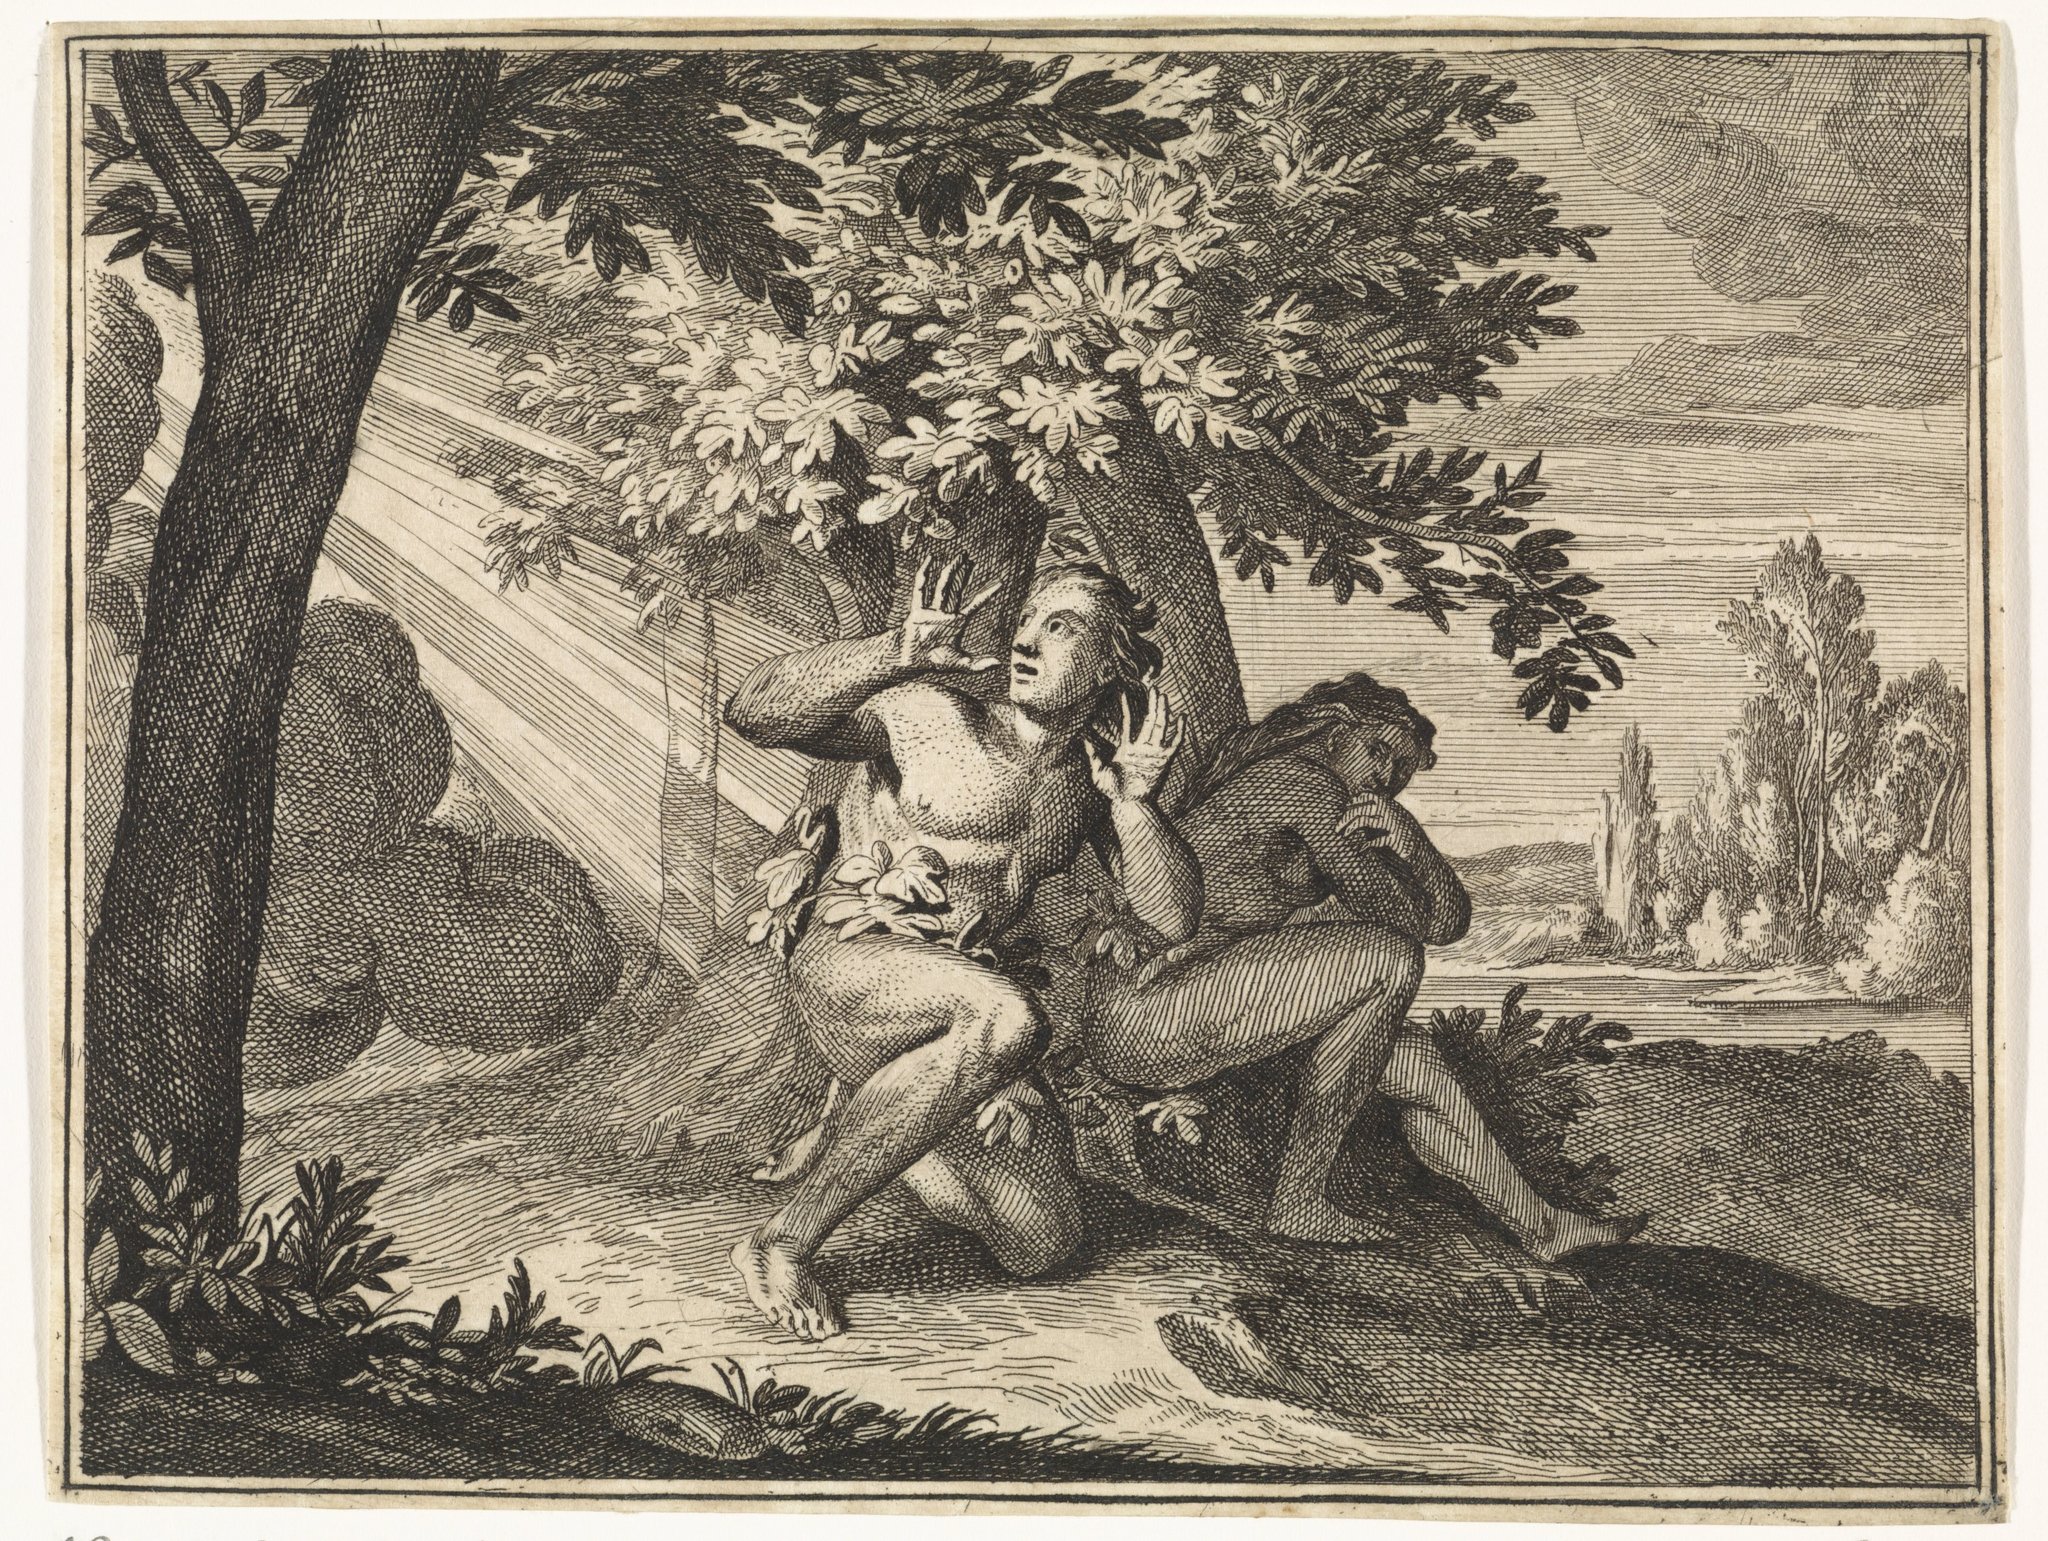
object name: print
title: Adam en Eva verbergen zich voor God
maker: caspar luyken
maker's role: draughtsman, print maker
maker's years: 1672-1708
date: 1712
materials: paper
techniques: etching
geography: amsterdam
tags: adam and eve discover their nakedness; they cover themselves with their hands or with leaves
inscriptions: number: ‘5’, collector's mark: Lugt 2228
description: Illustratie uit: Luyken, Jan. De schriftuurlyke geschiedenissen en gelykenissen van het Oude en Nieuwe Verbond, 2 delen. Amsterdam: Wed. Pieter Arentsz II en Cornelis van der Sys, 1712, dl. I.